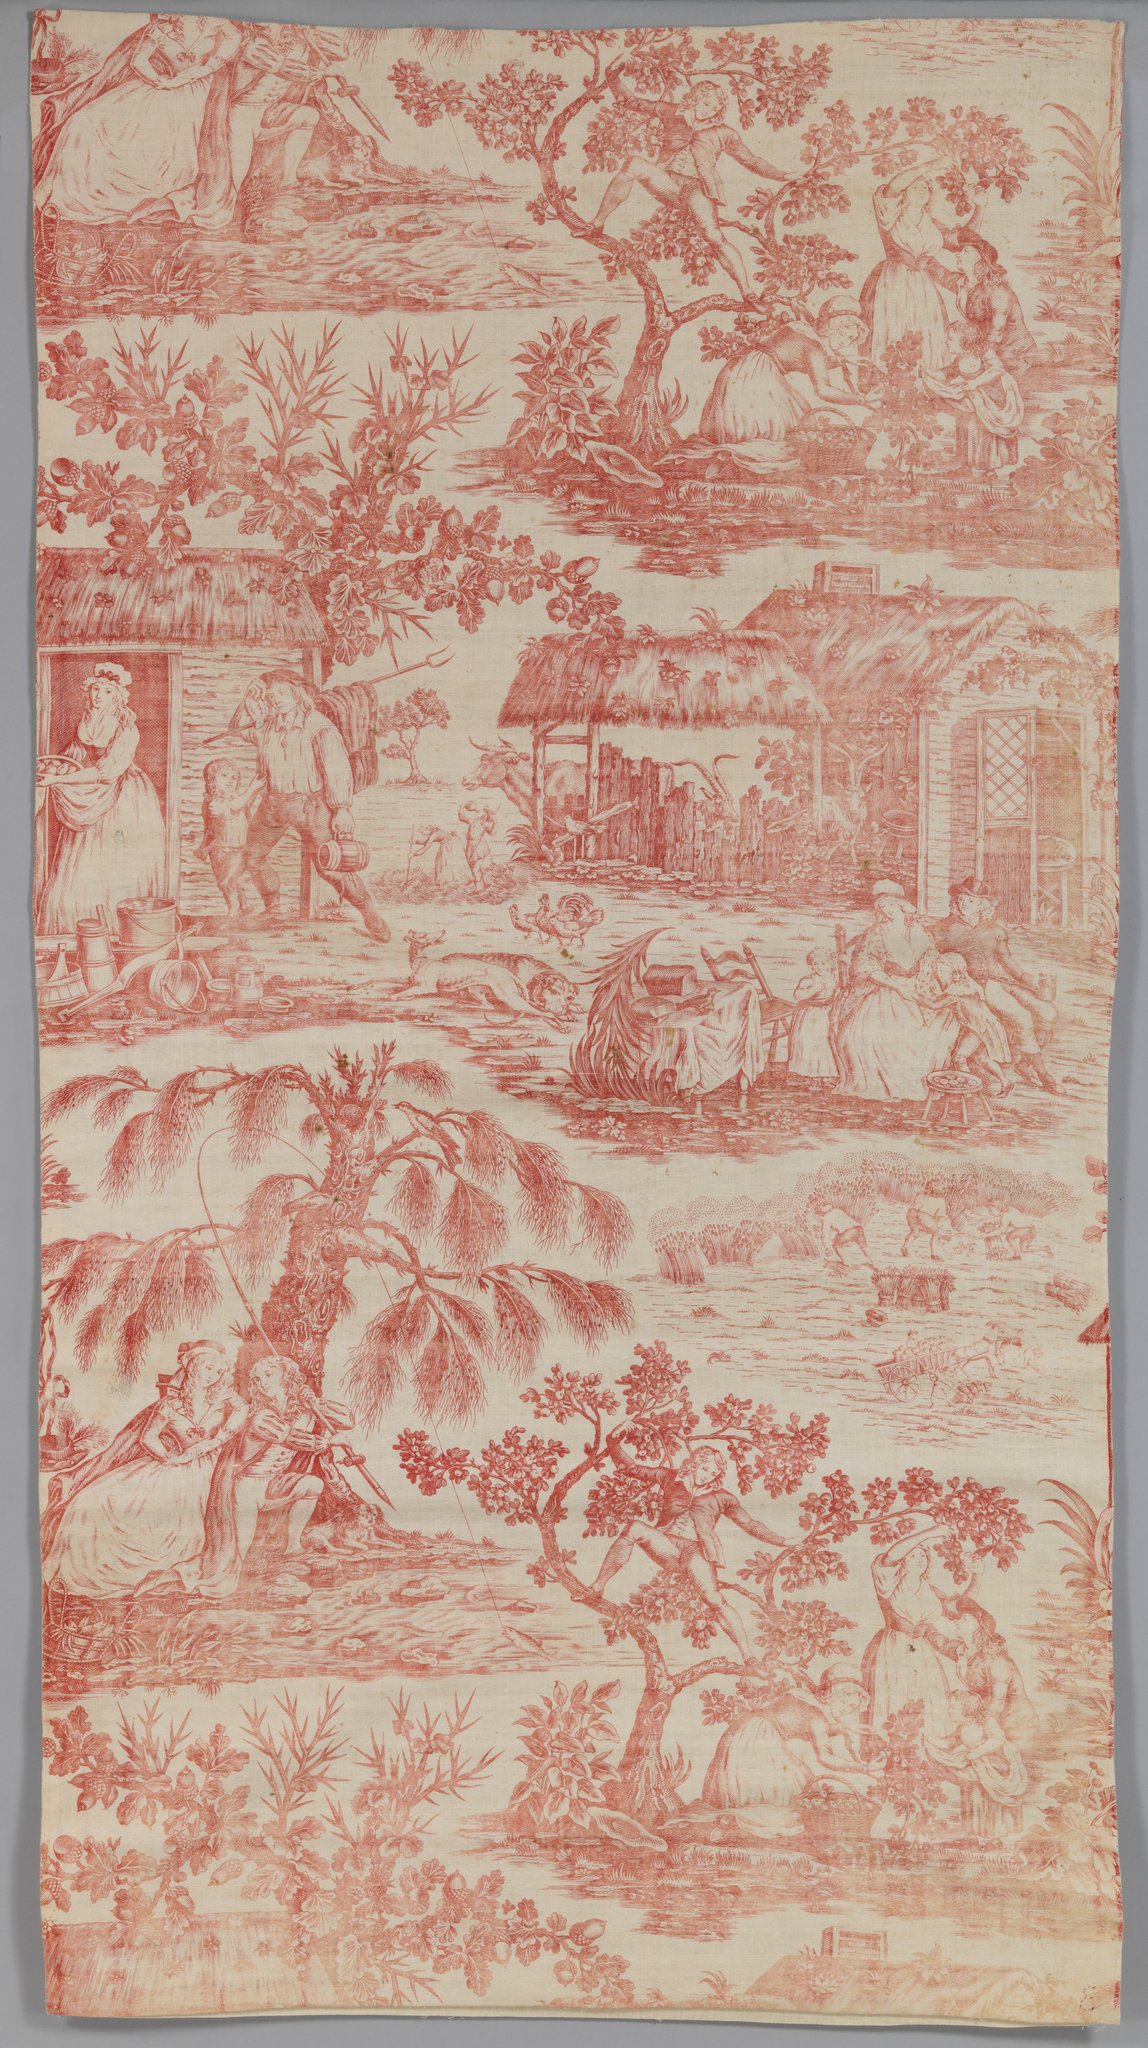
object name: furnishing textile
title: Pastoral scenes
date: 1790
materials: cotton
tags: animals,houses,men,women,pastoral